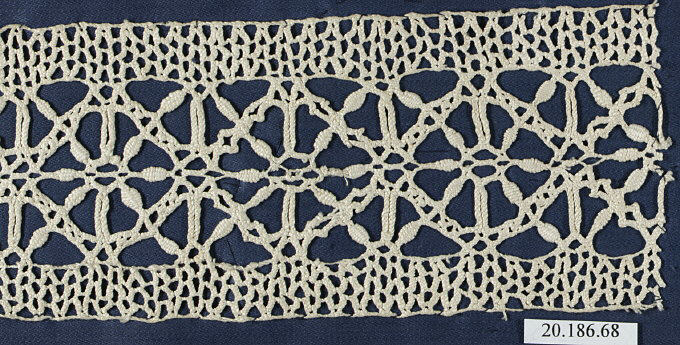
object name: insertion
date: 1501-1600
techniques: lace